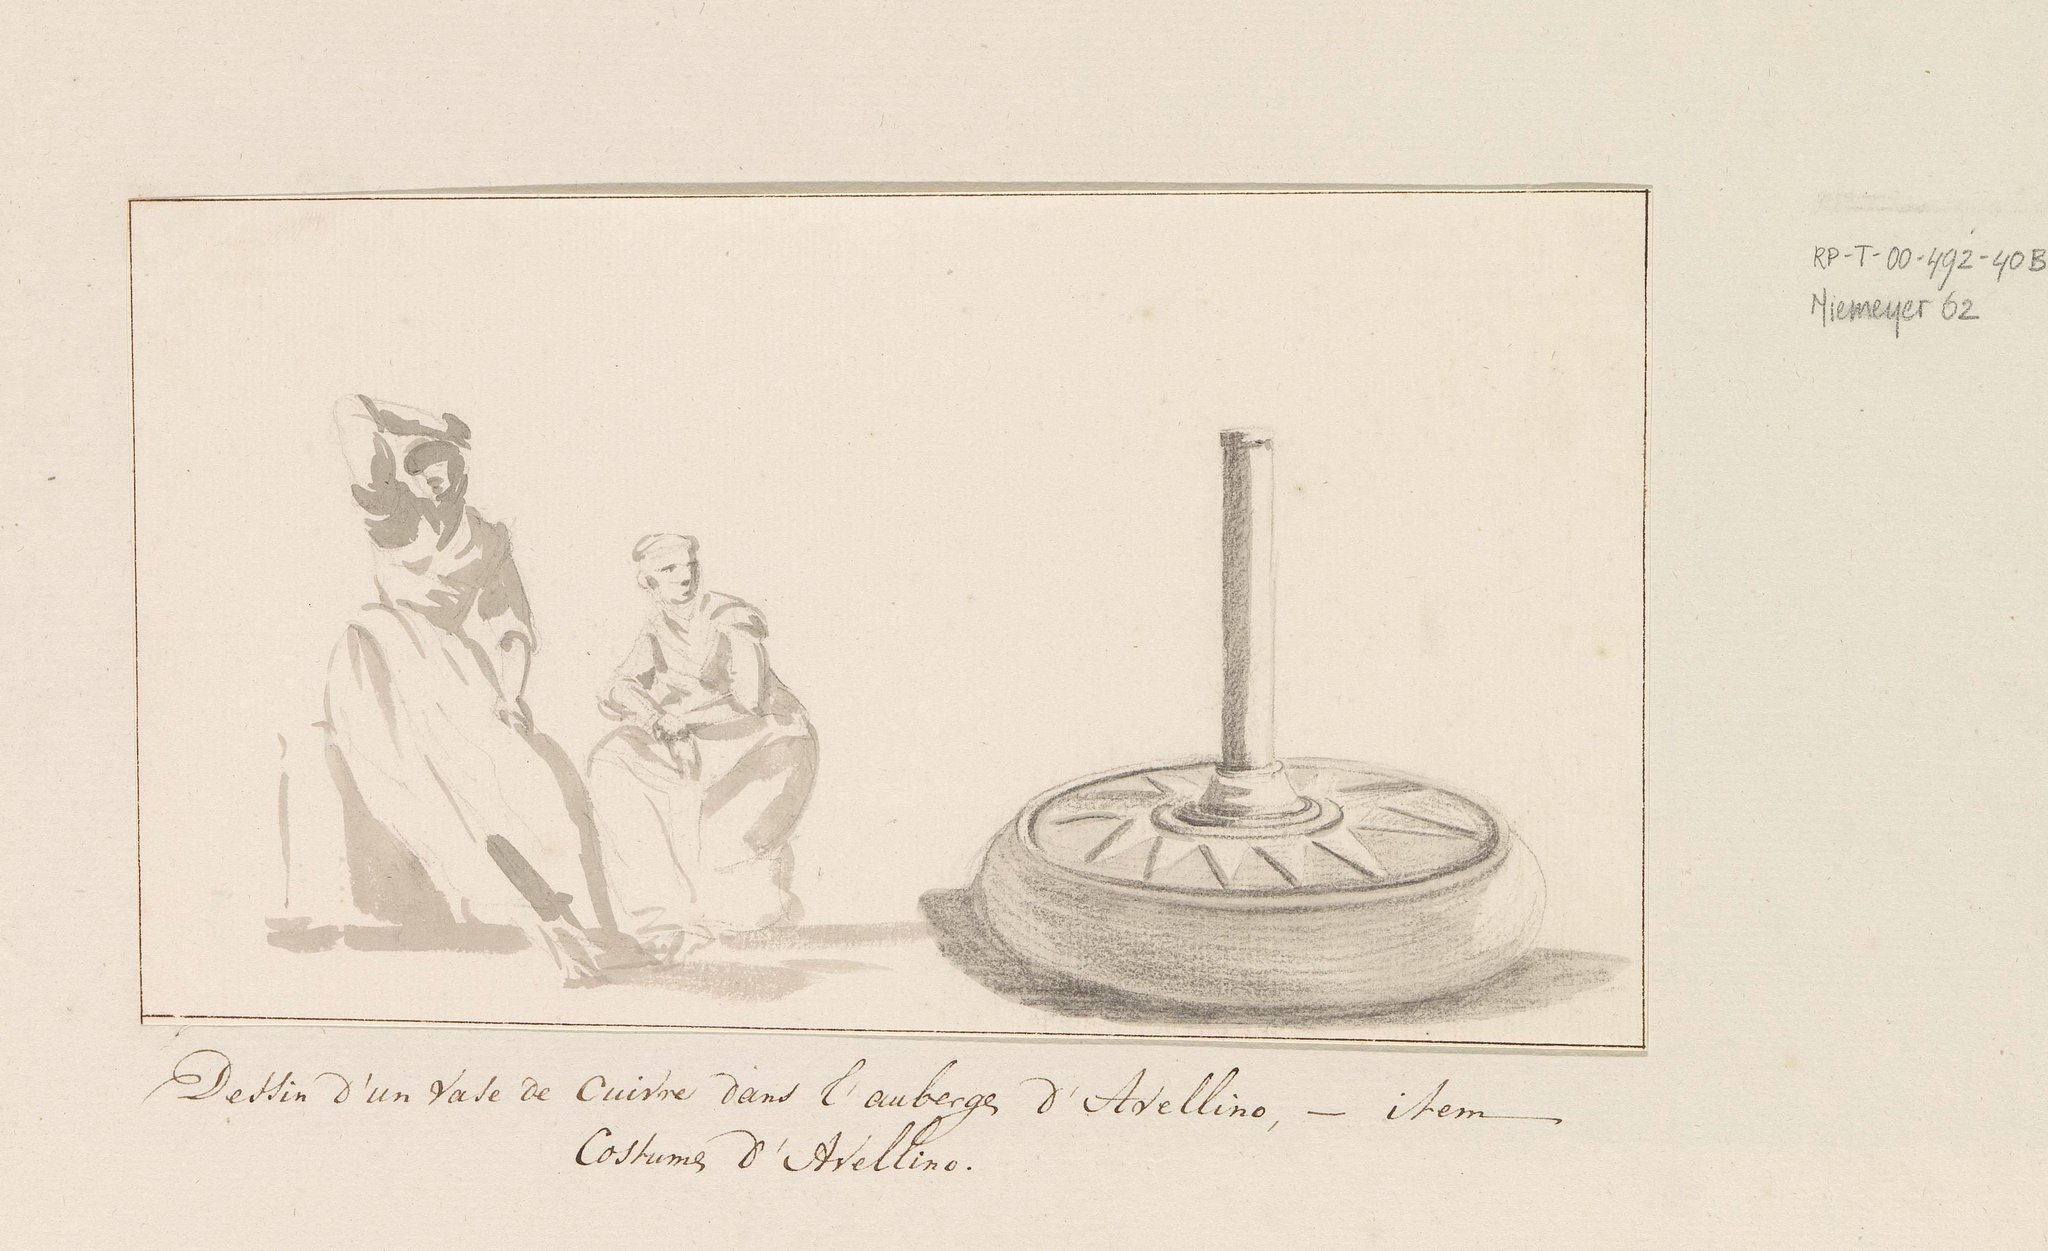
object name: drawing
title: Ontwerp op koperen vaas in herberg te Avellino en twee vrouwen in klederdracht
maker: louis ducros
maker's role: draughtsman, print maker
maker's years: 1748-1810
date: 1778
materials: chalk, paper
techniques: brush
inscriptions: number: ‘No 40 Dessin d'un Vase de Cuivre dans l'auberge d'Avellino, Costumes d'Avellino’